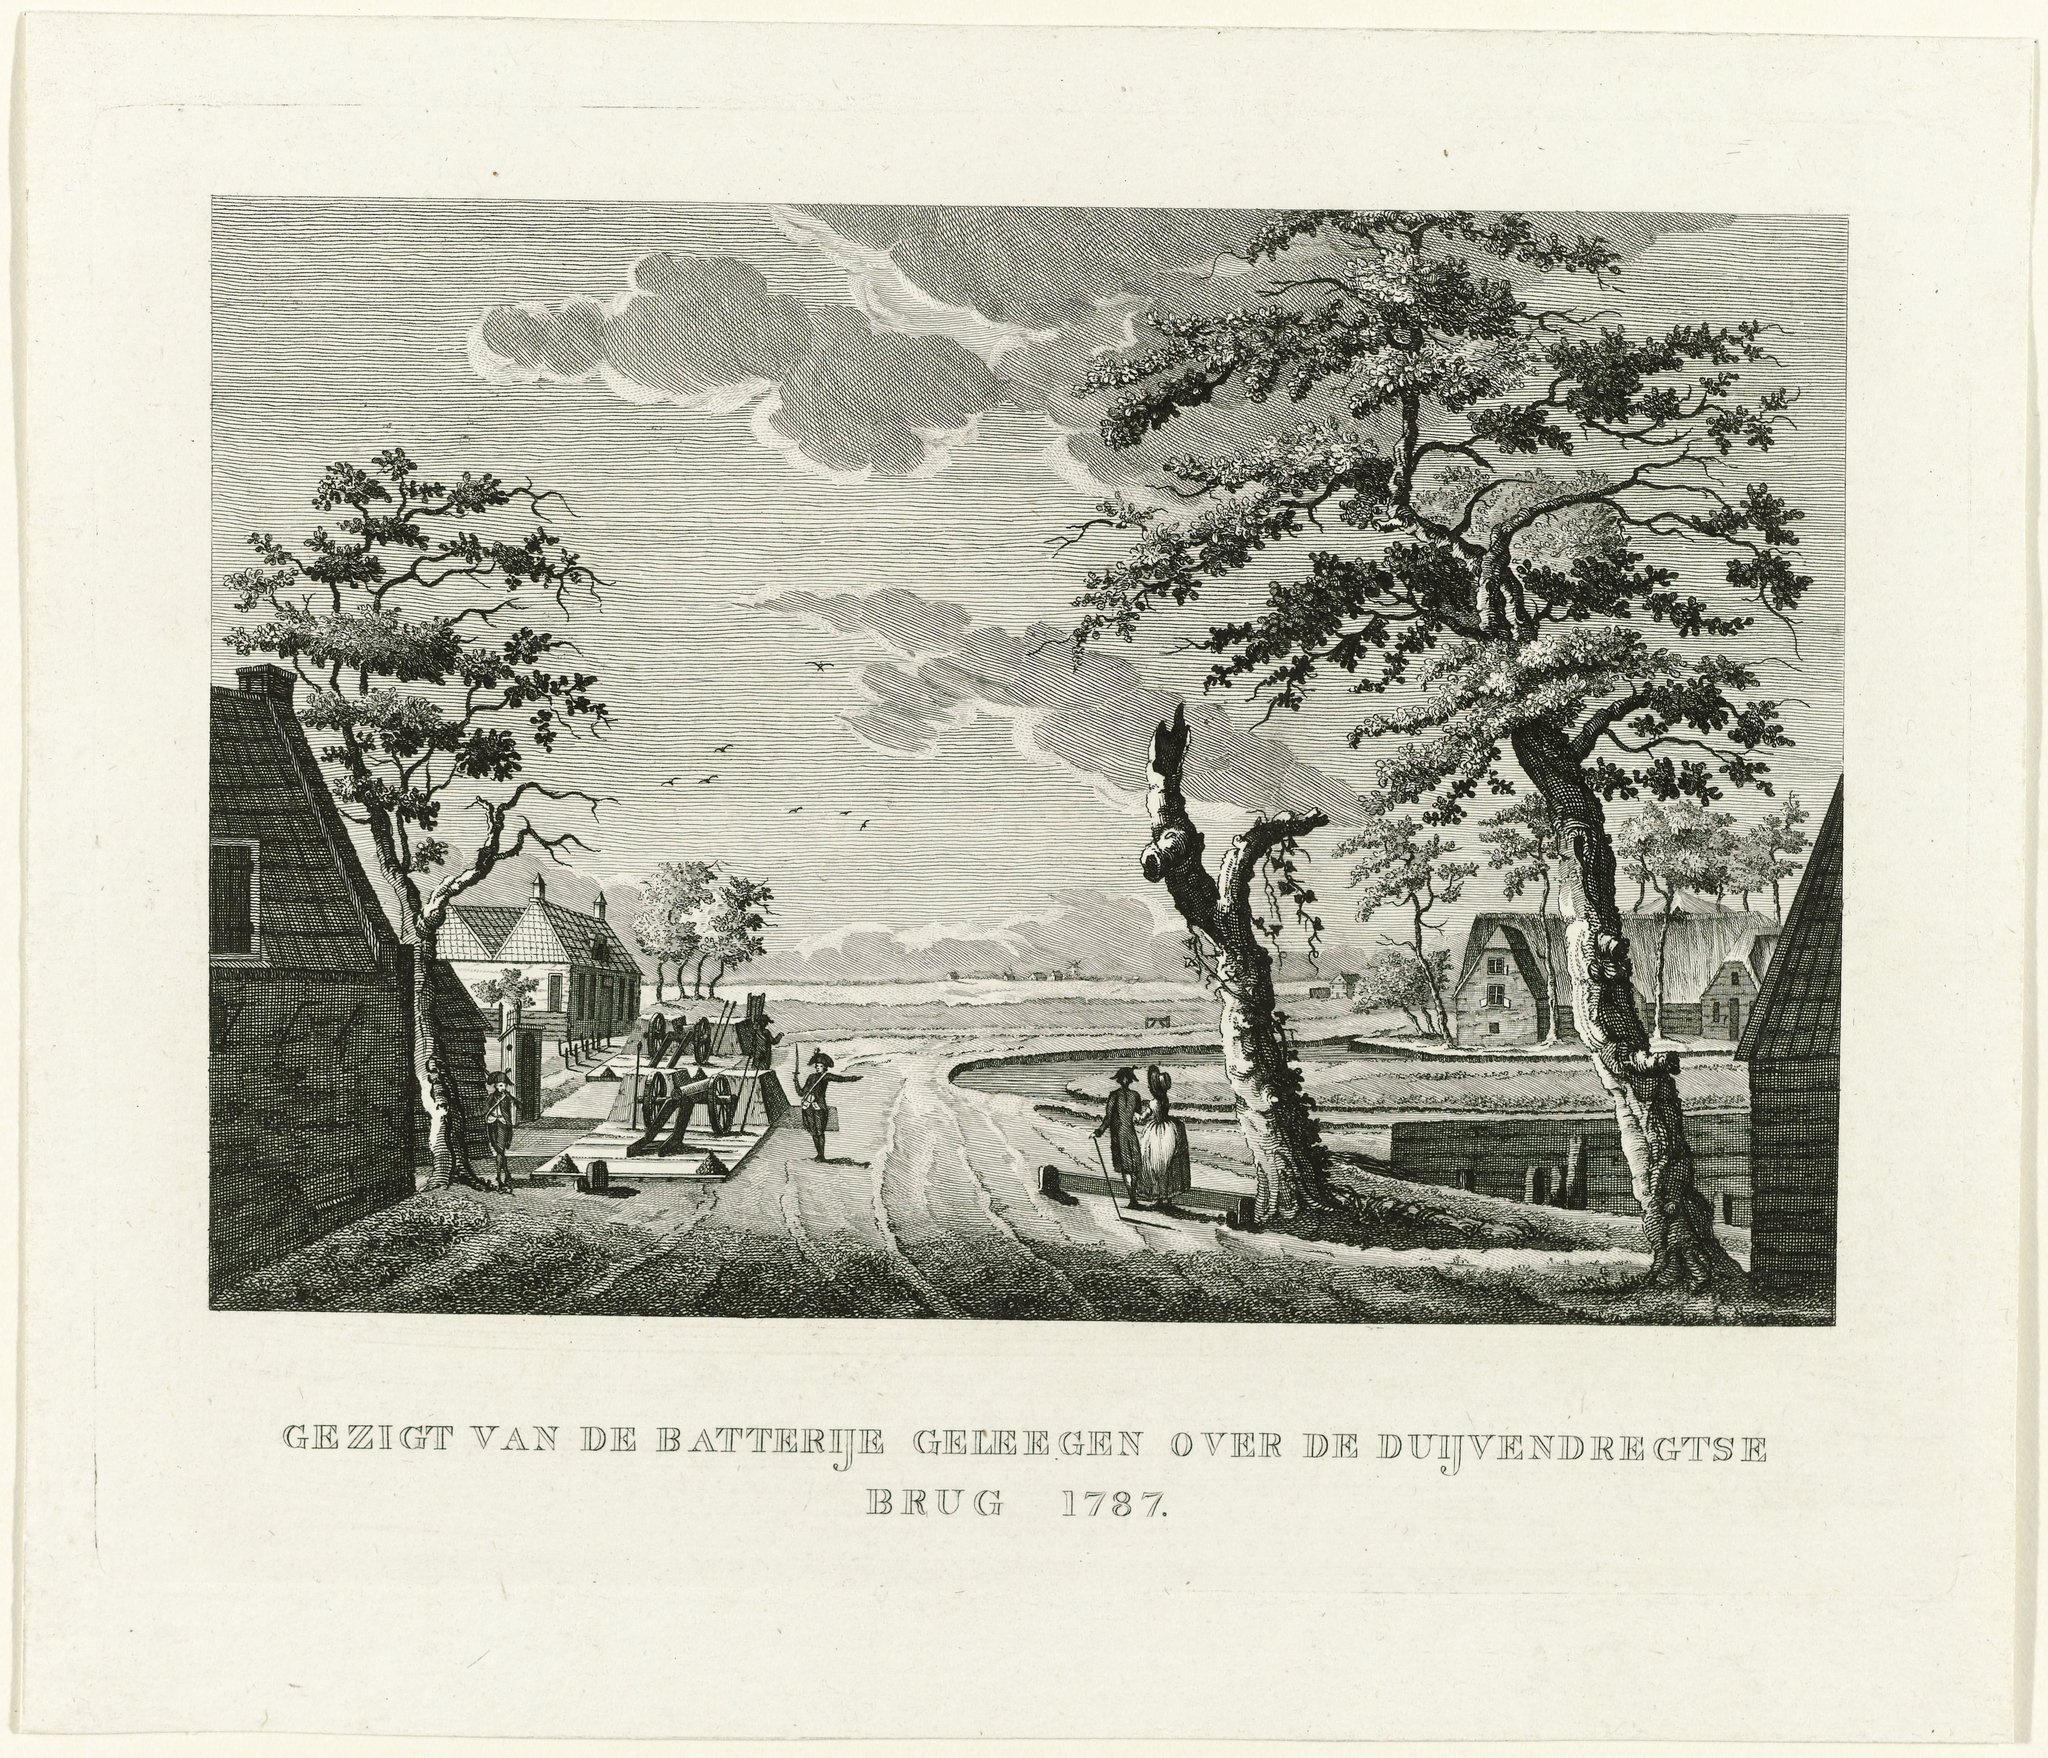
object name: print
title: Gezigt van de batterije geleegen over de Duijvendregtse Brug 1787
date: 1787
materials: paper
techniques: engraving, etching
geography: northern netherlands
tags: defence of fortification or city, defensive measures (military)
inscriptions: collector's mark: Lugt 2228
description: Battterij over de Duivendrechtsebrug. Onderdeel van een serie van veertien platen (waarvan de dertiende prent ontbreekt), gekopieerd naar de eerste reeks van platen van de verdedigingen aangelegd door de patriotten rondom Amsterdam ten tijde van de inval van de Pruisische troepen in september 1787.